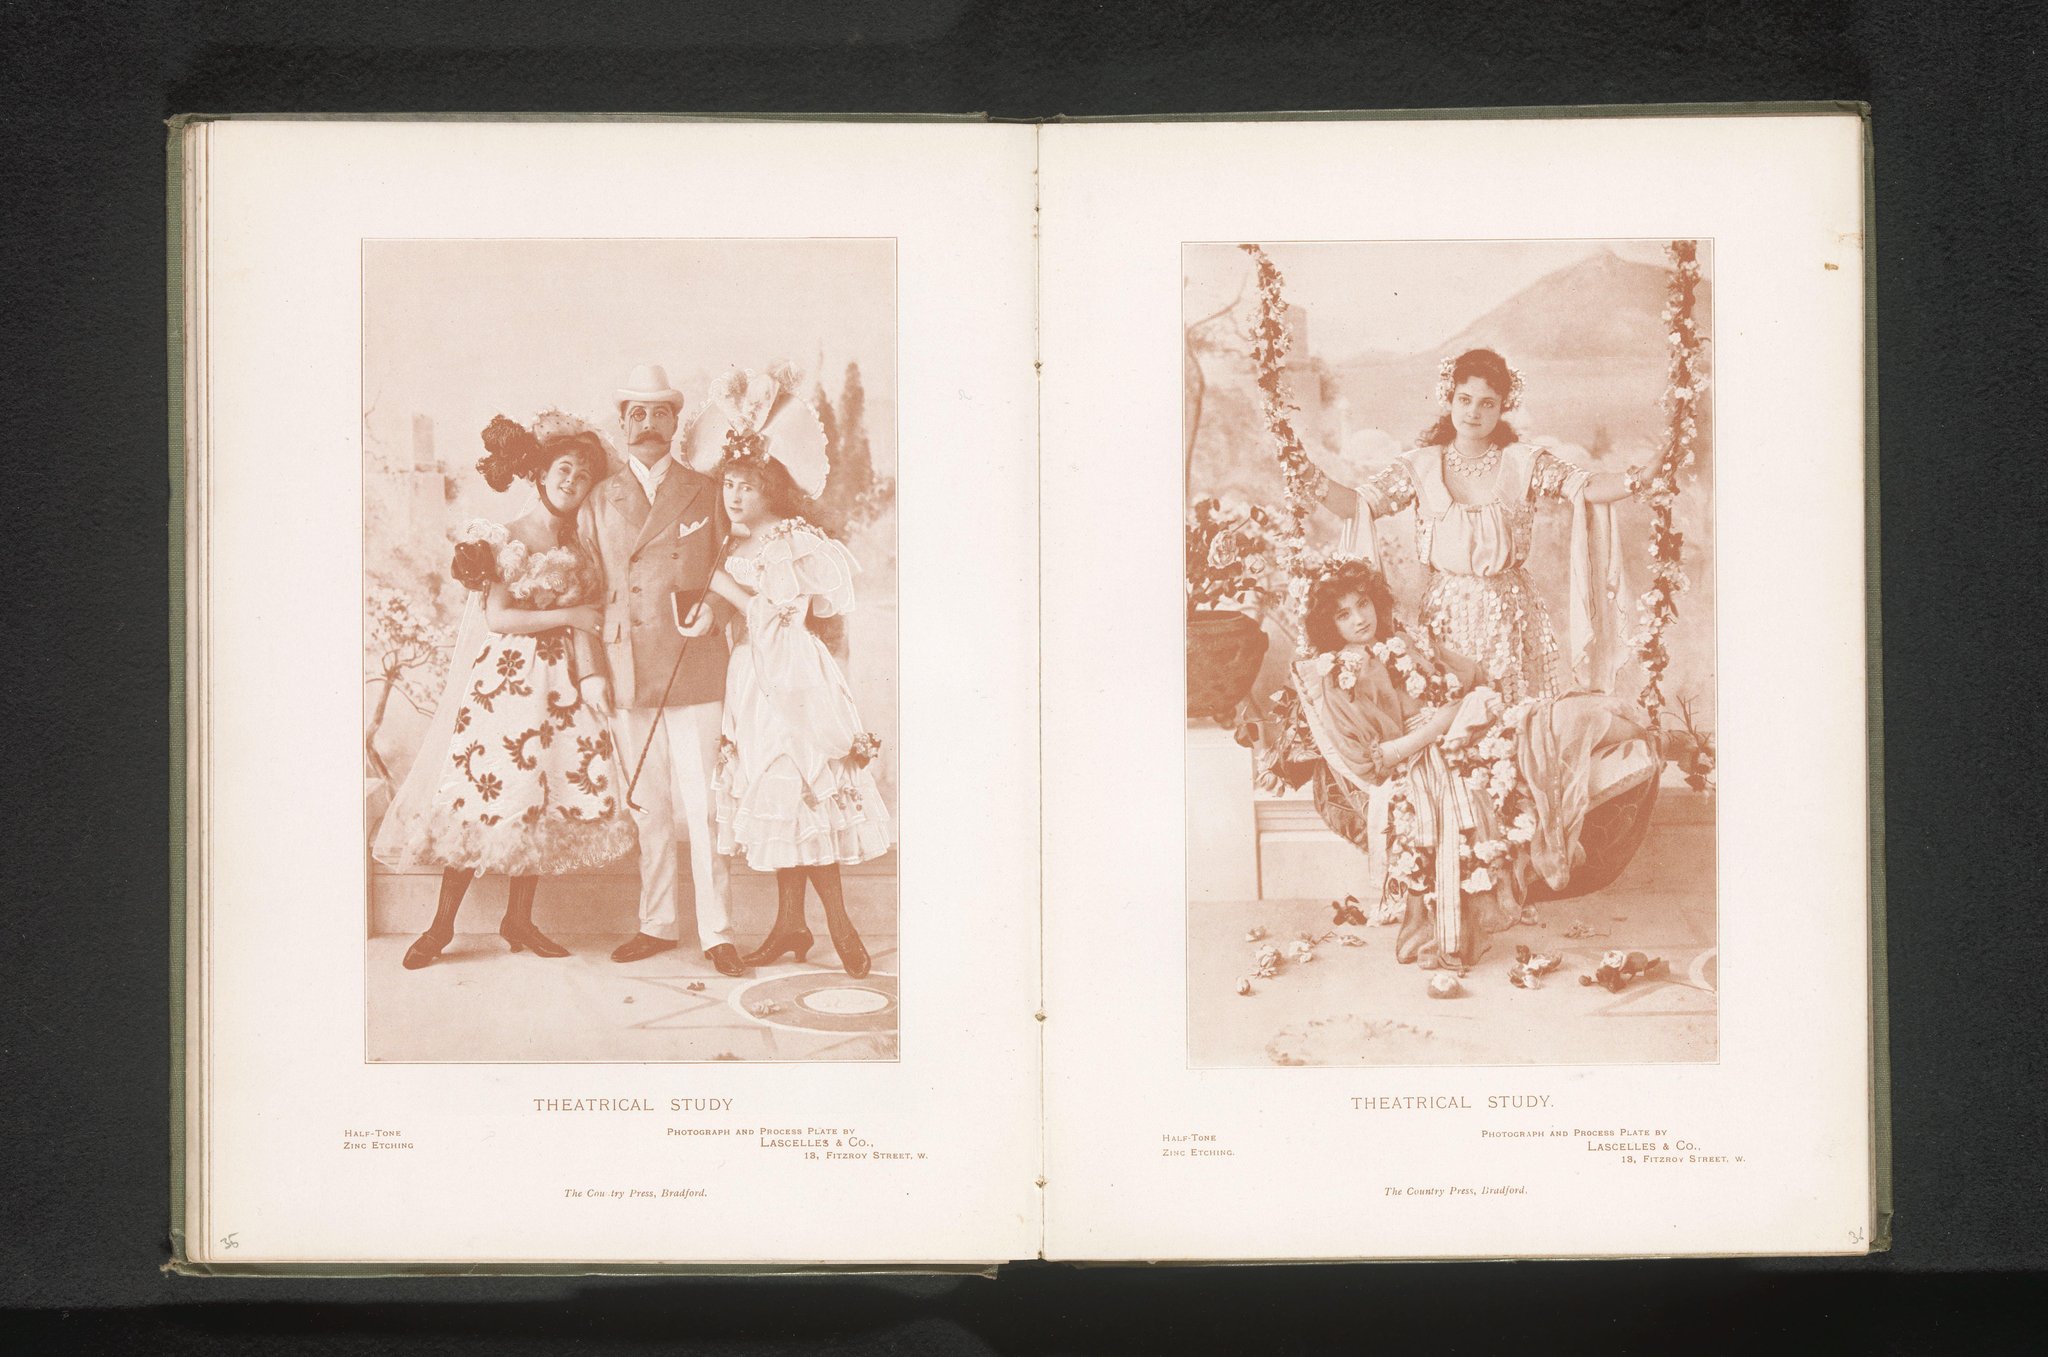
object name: photomechanical print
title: Theatrical study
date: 1893-1898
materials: paper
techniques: autotype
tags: portrait of actor, actress, anonymous historical persons portrayed in a group, in a group-portrait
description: Prent op derde ongenummerde pagina na pagina 40.